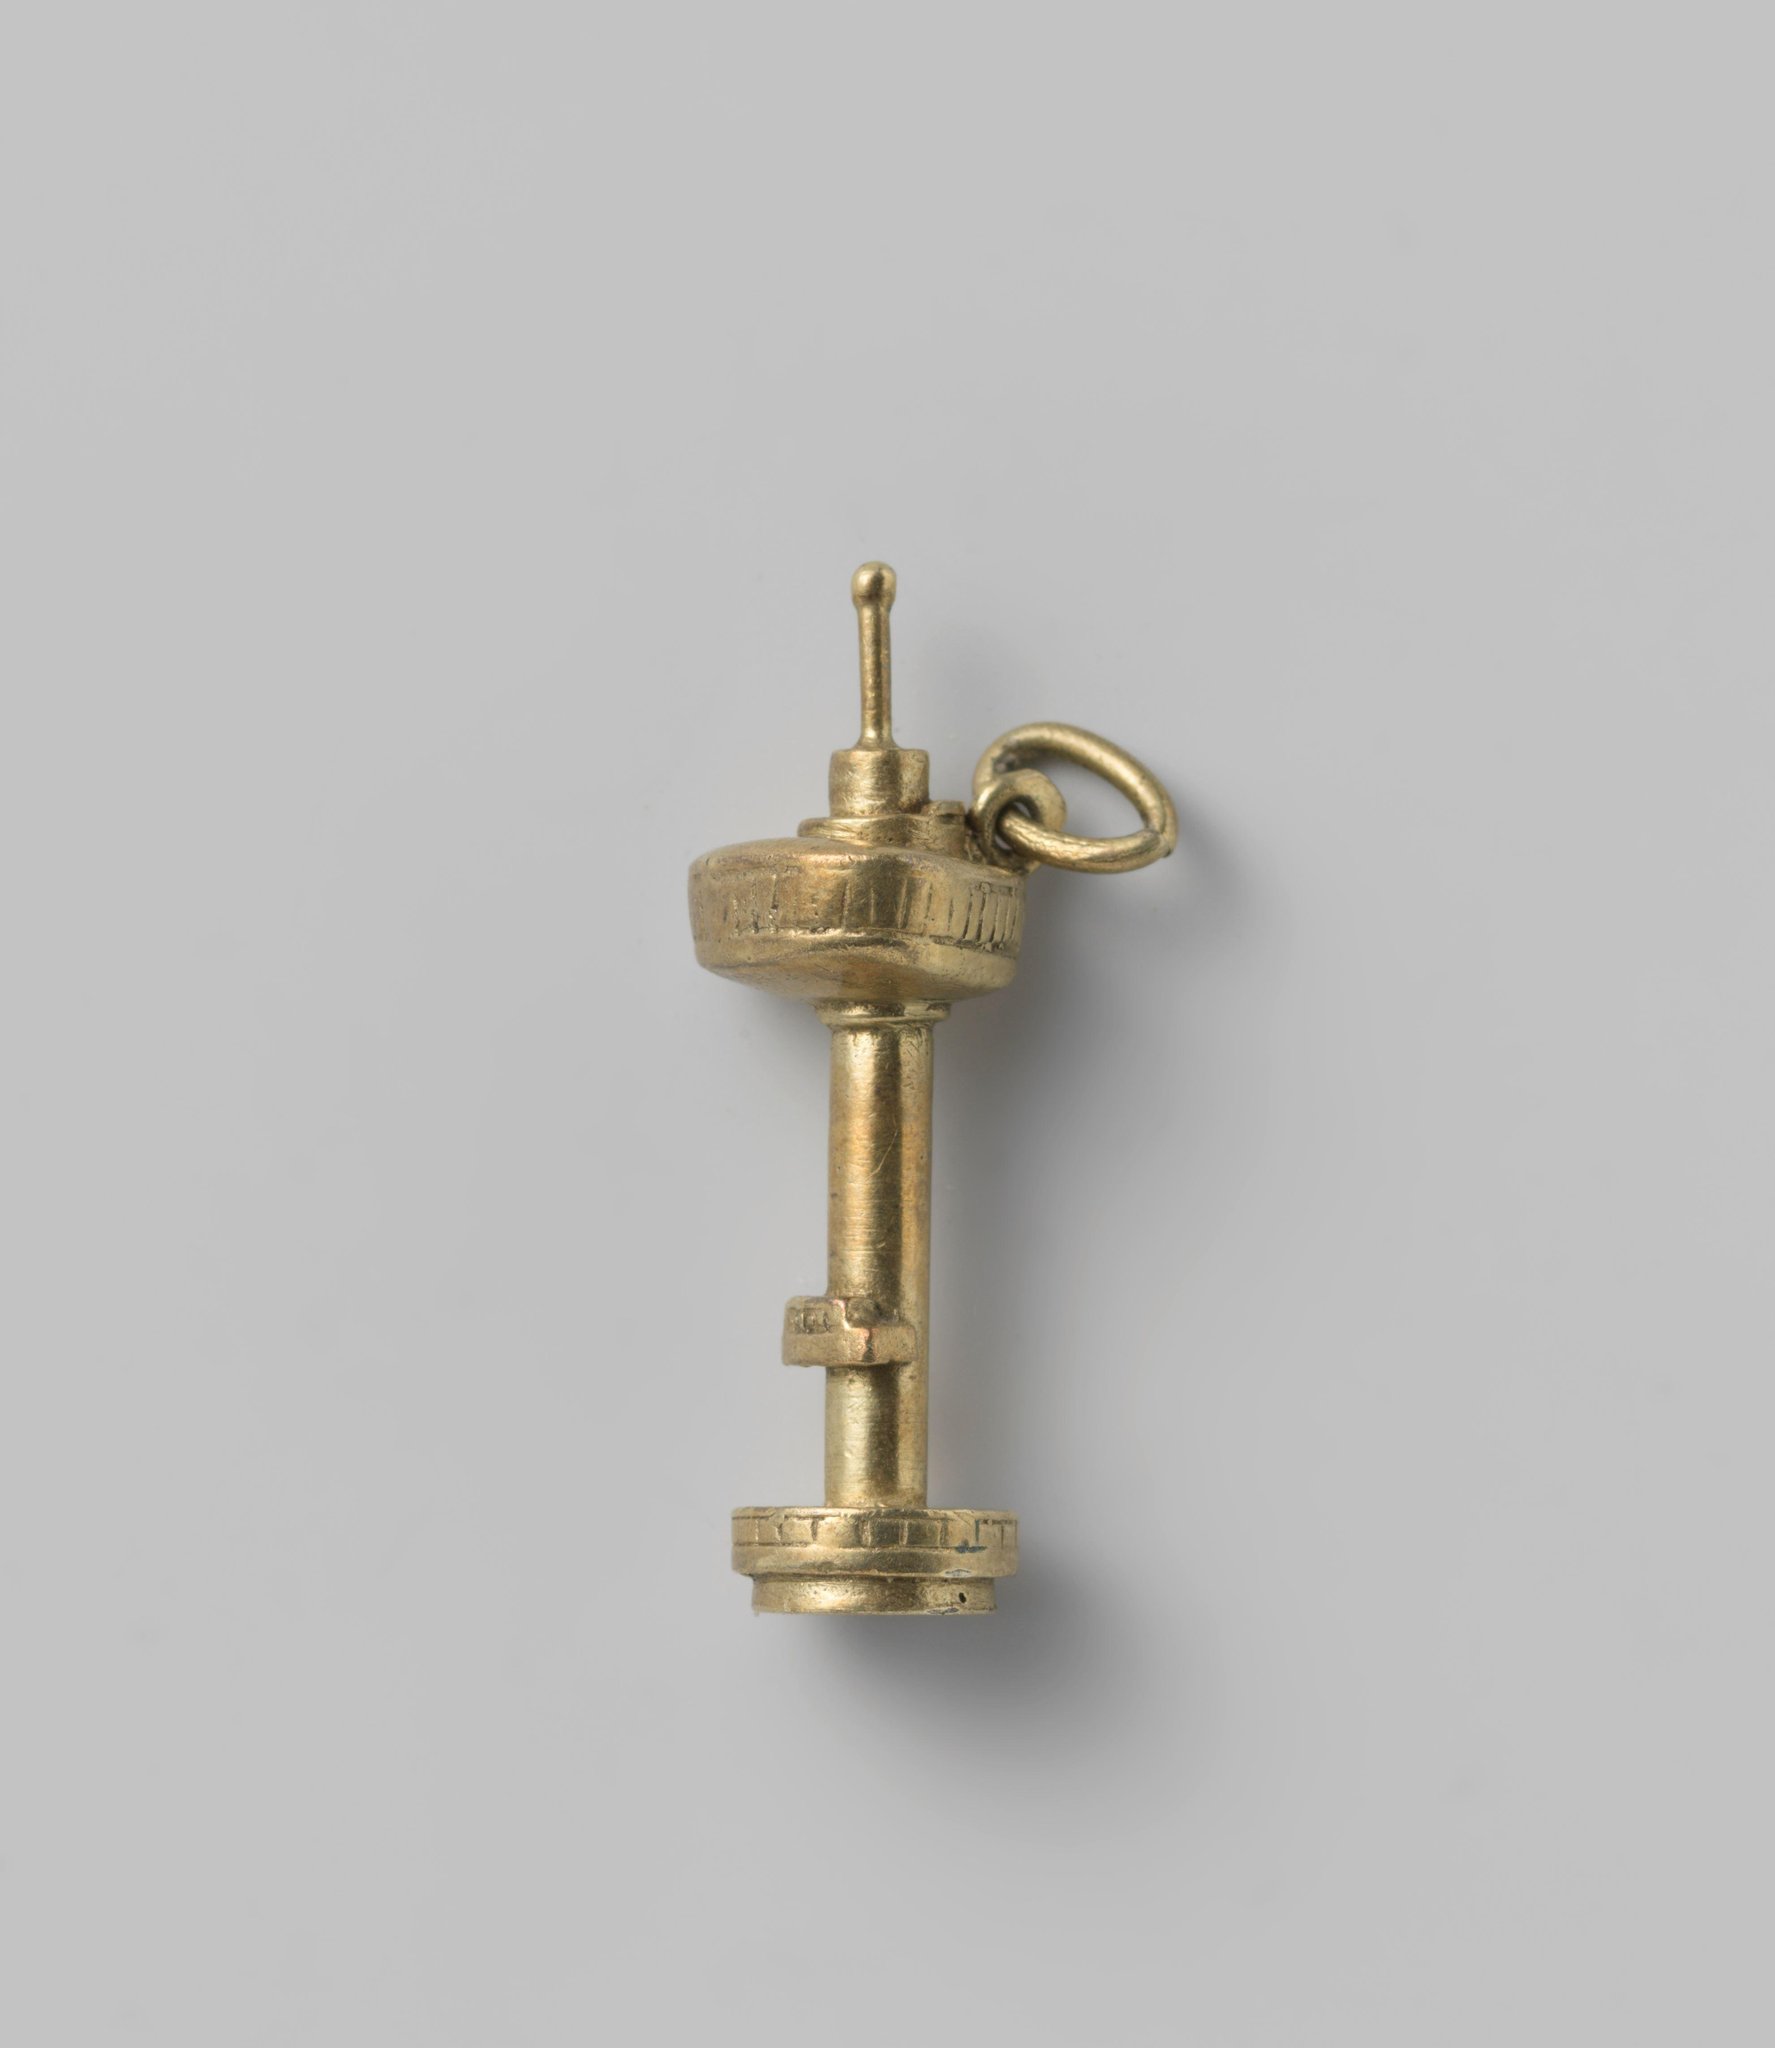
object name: charm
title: Bedel van de Euromast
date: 1958-1970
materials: silver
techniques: gilding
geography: rotterdam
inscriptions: maker's mark: ‘EdG’, alloy mark: ‘zwaard 835’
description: Bedel van de Euromast te Rotterdam van verguld zilver.